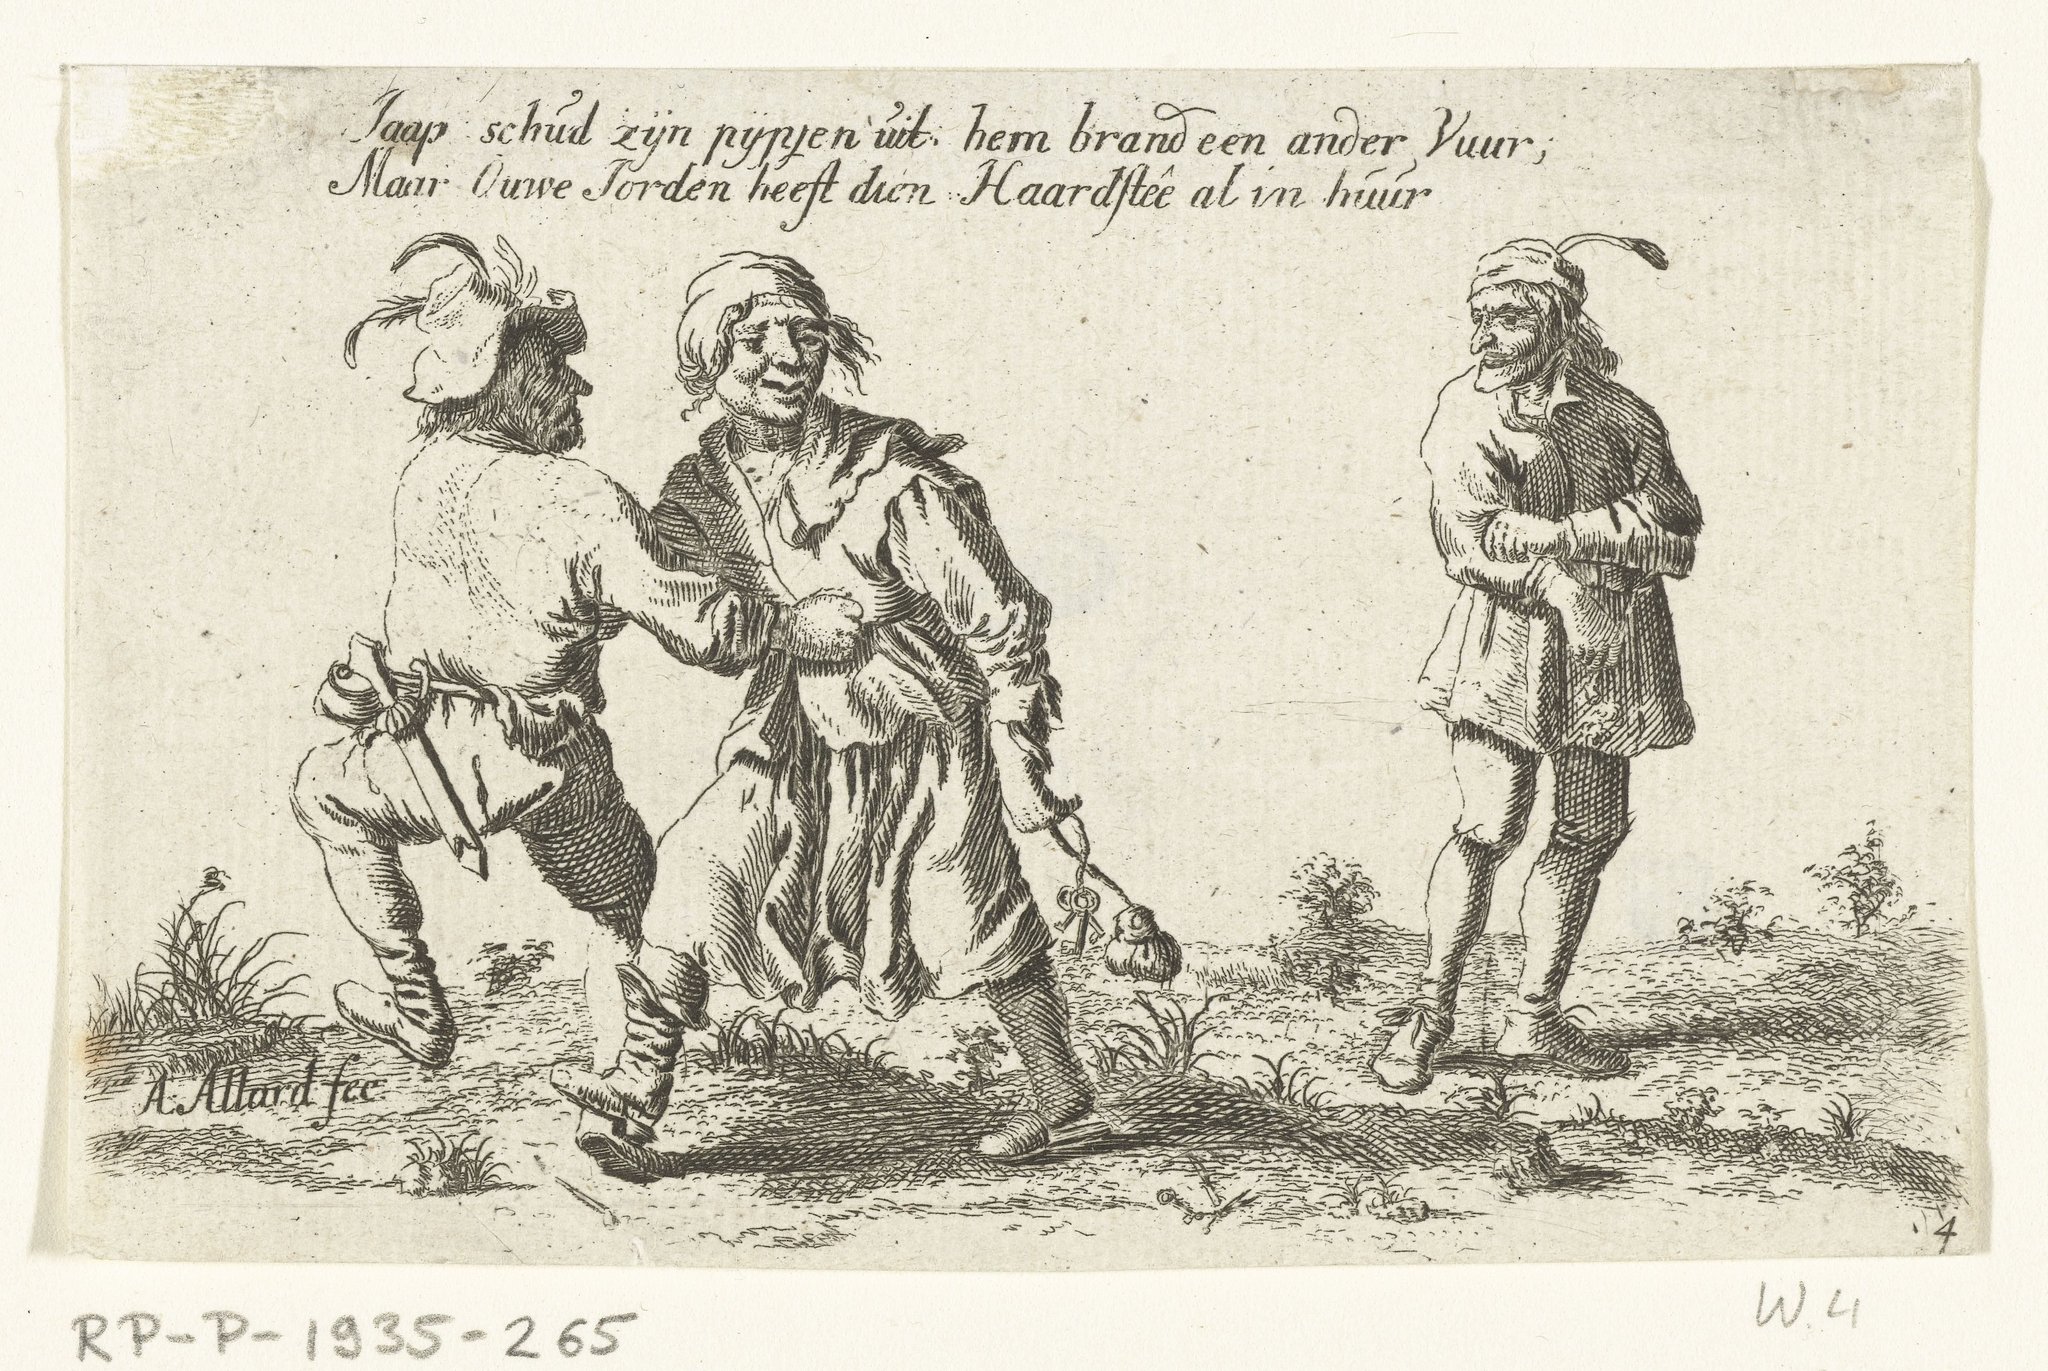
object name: print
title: Twee dansende boeren en één die toekijkt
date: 1686-1709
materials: paper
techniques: engraving, etching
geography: amsterdam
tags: farmers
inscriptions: collector's mark: Lugt 2228, collector's mark: Lugt 2760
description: Twee dansende boeren, een derde staat ernaar te kijken. Met tweeregelig opschrift in het Nederlands.